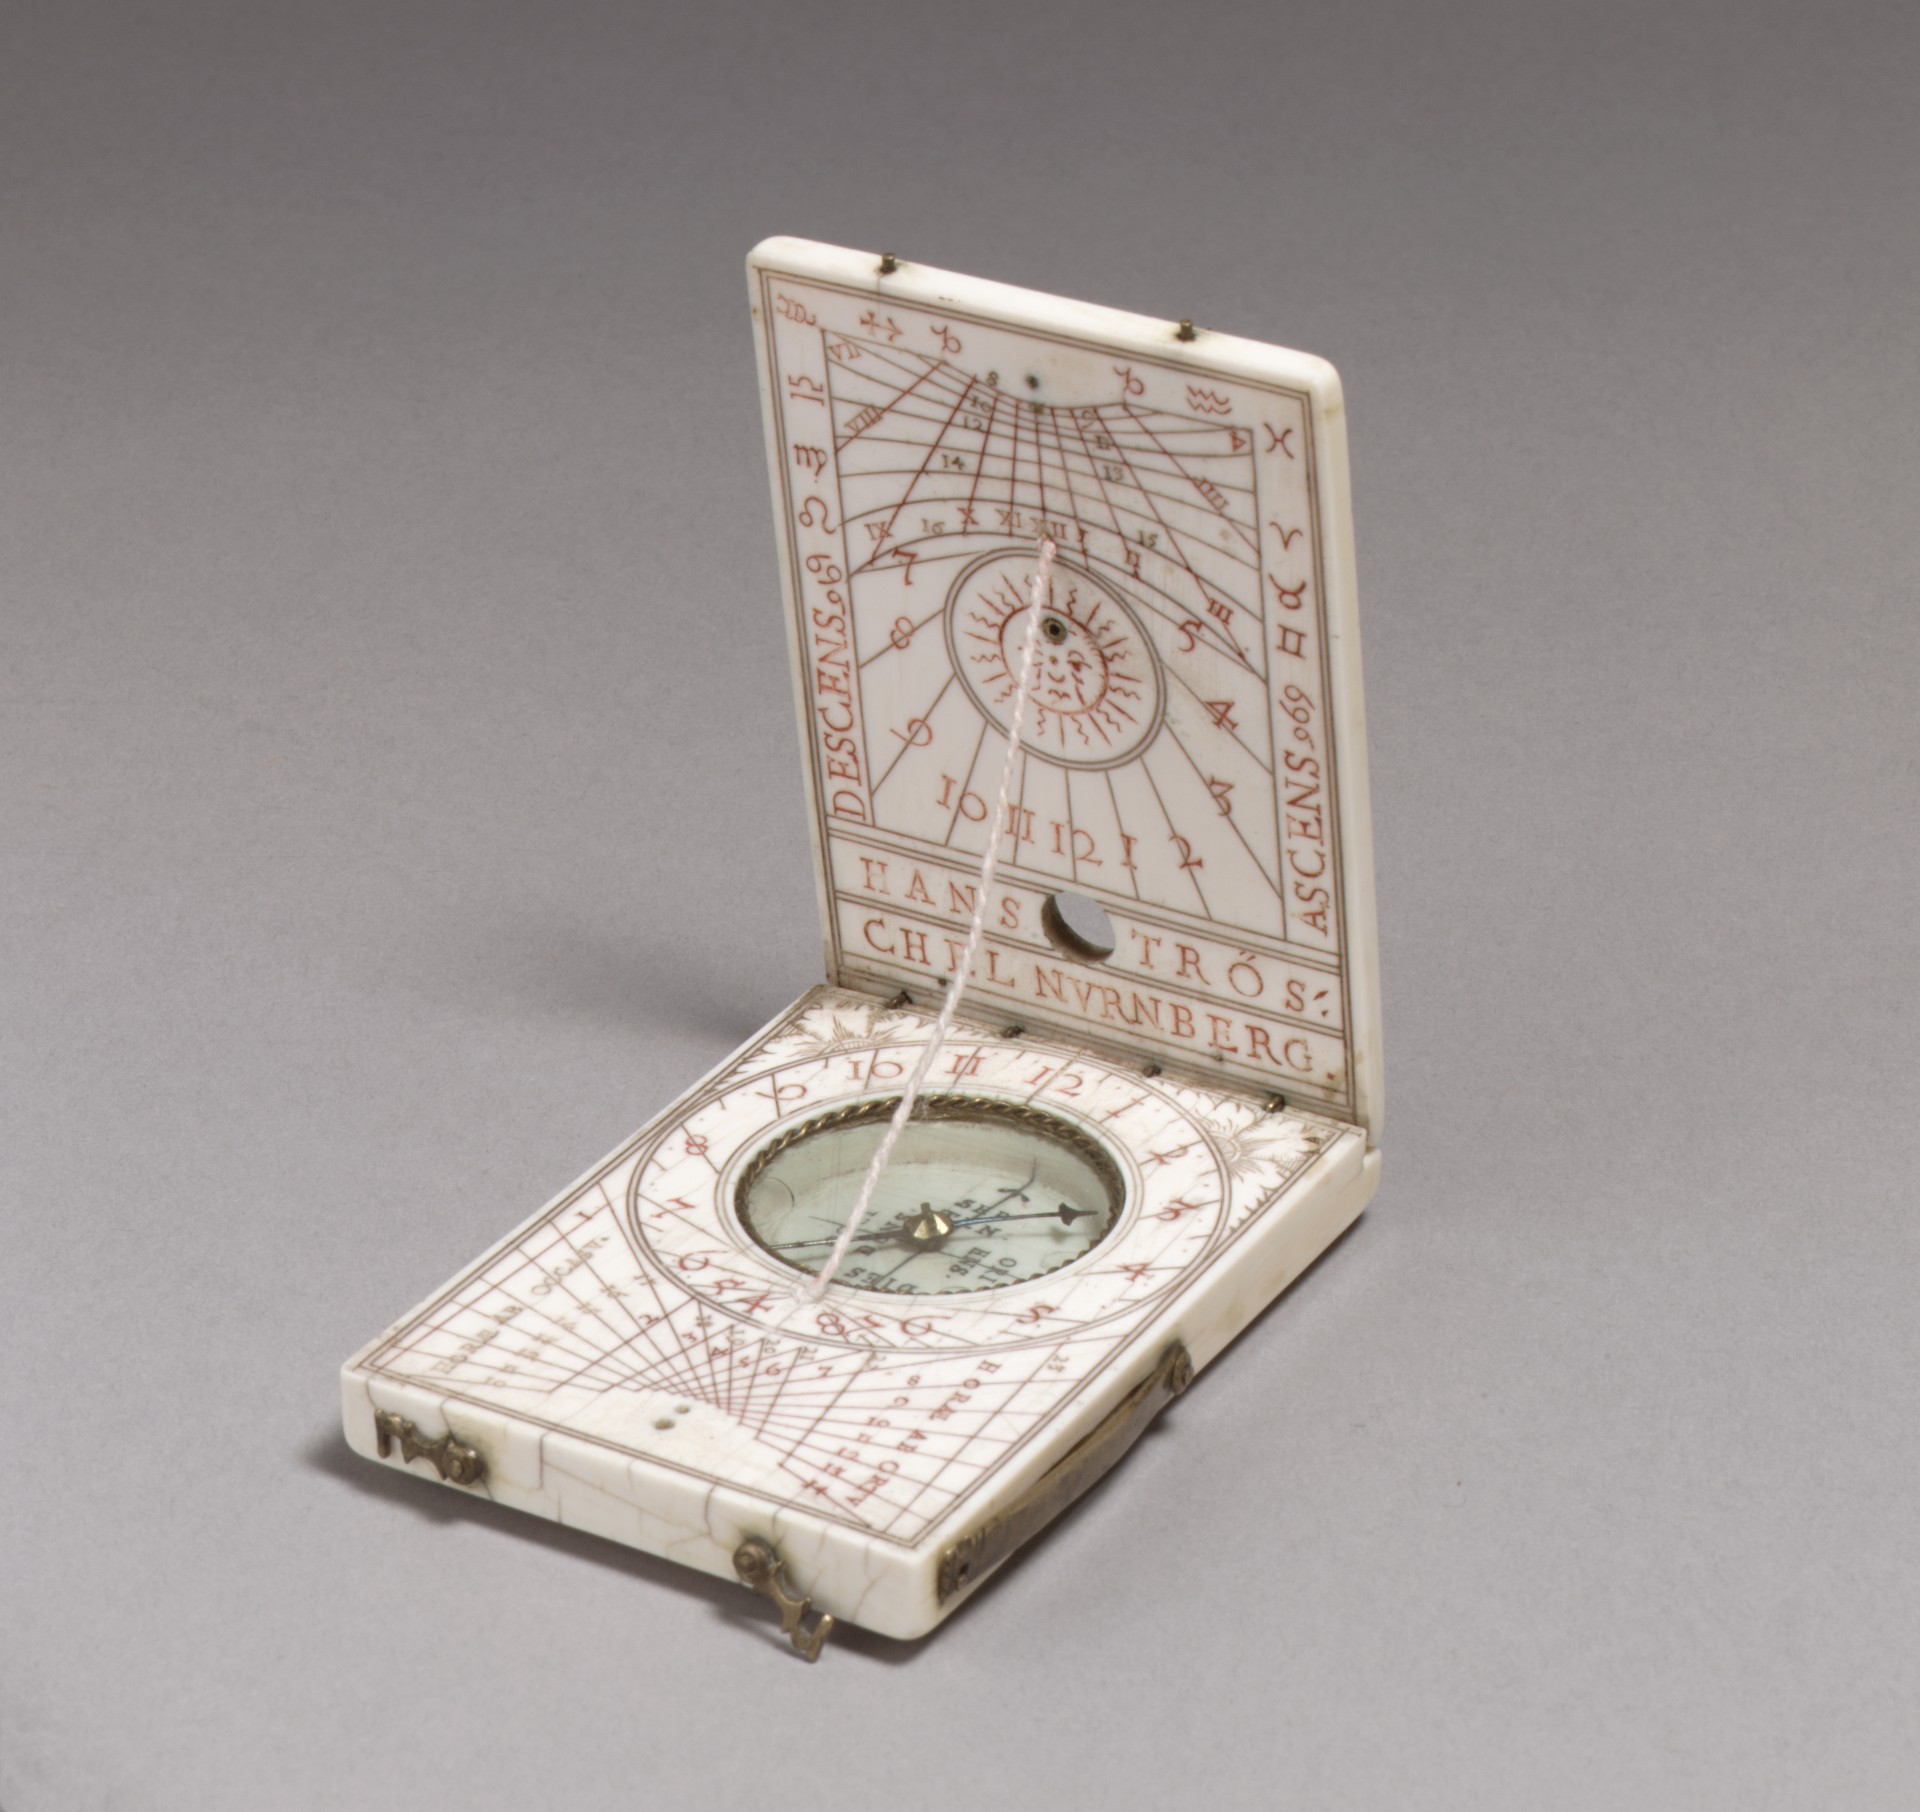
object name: portable diptych sundial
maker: hans tröschel the elder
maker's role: maker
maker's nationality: german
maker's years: 1549-1612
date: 1598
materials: brass, ivory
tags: sundials